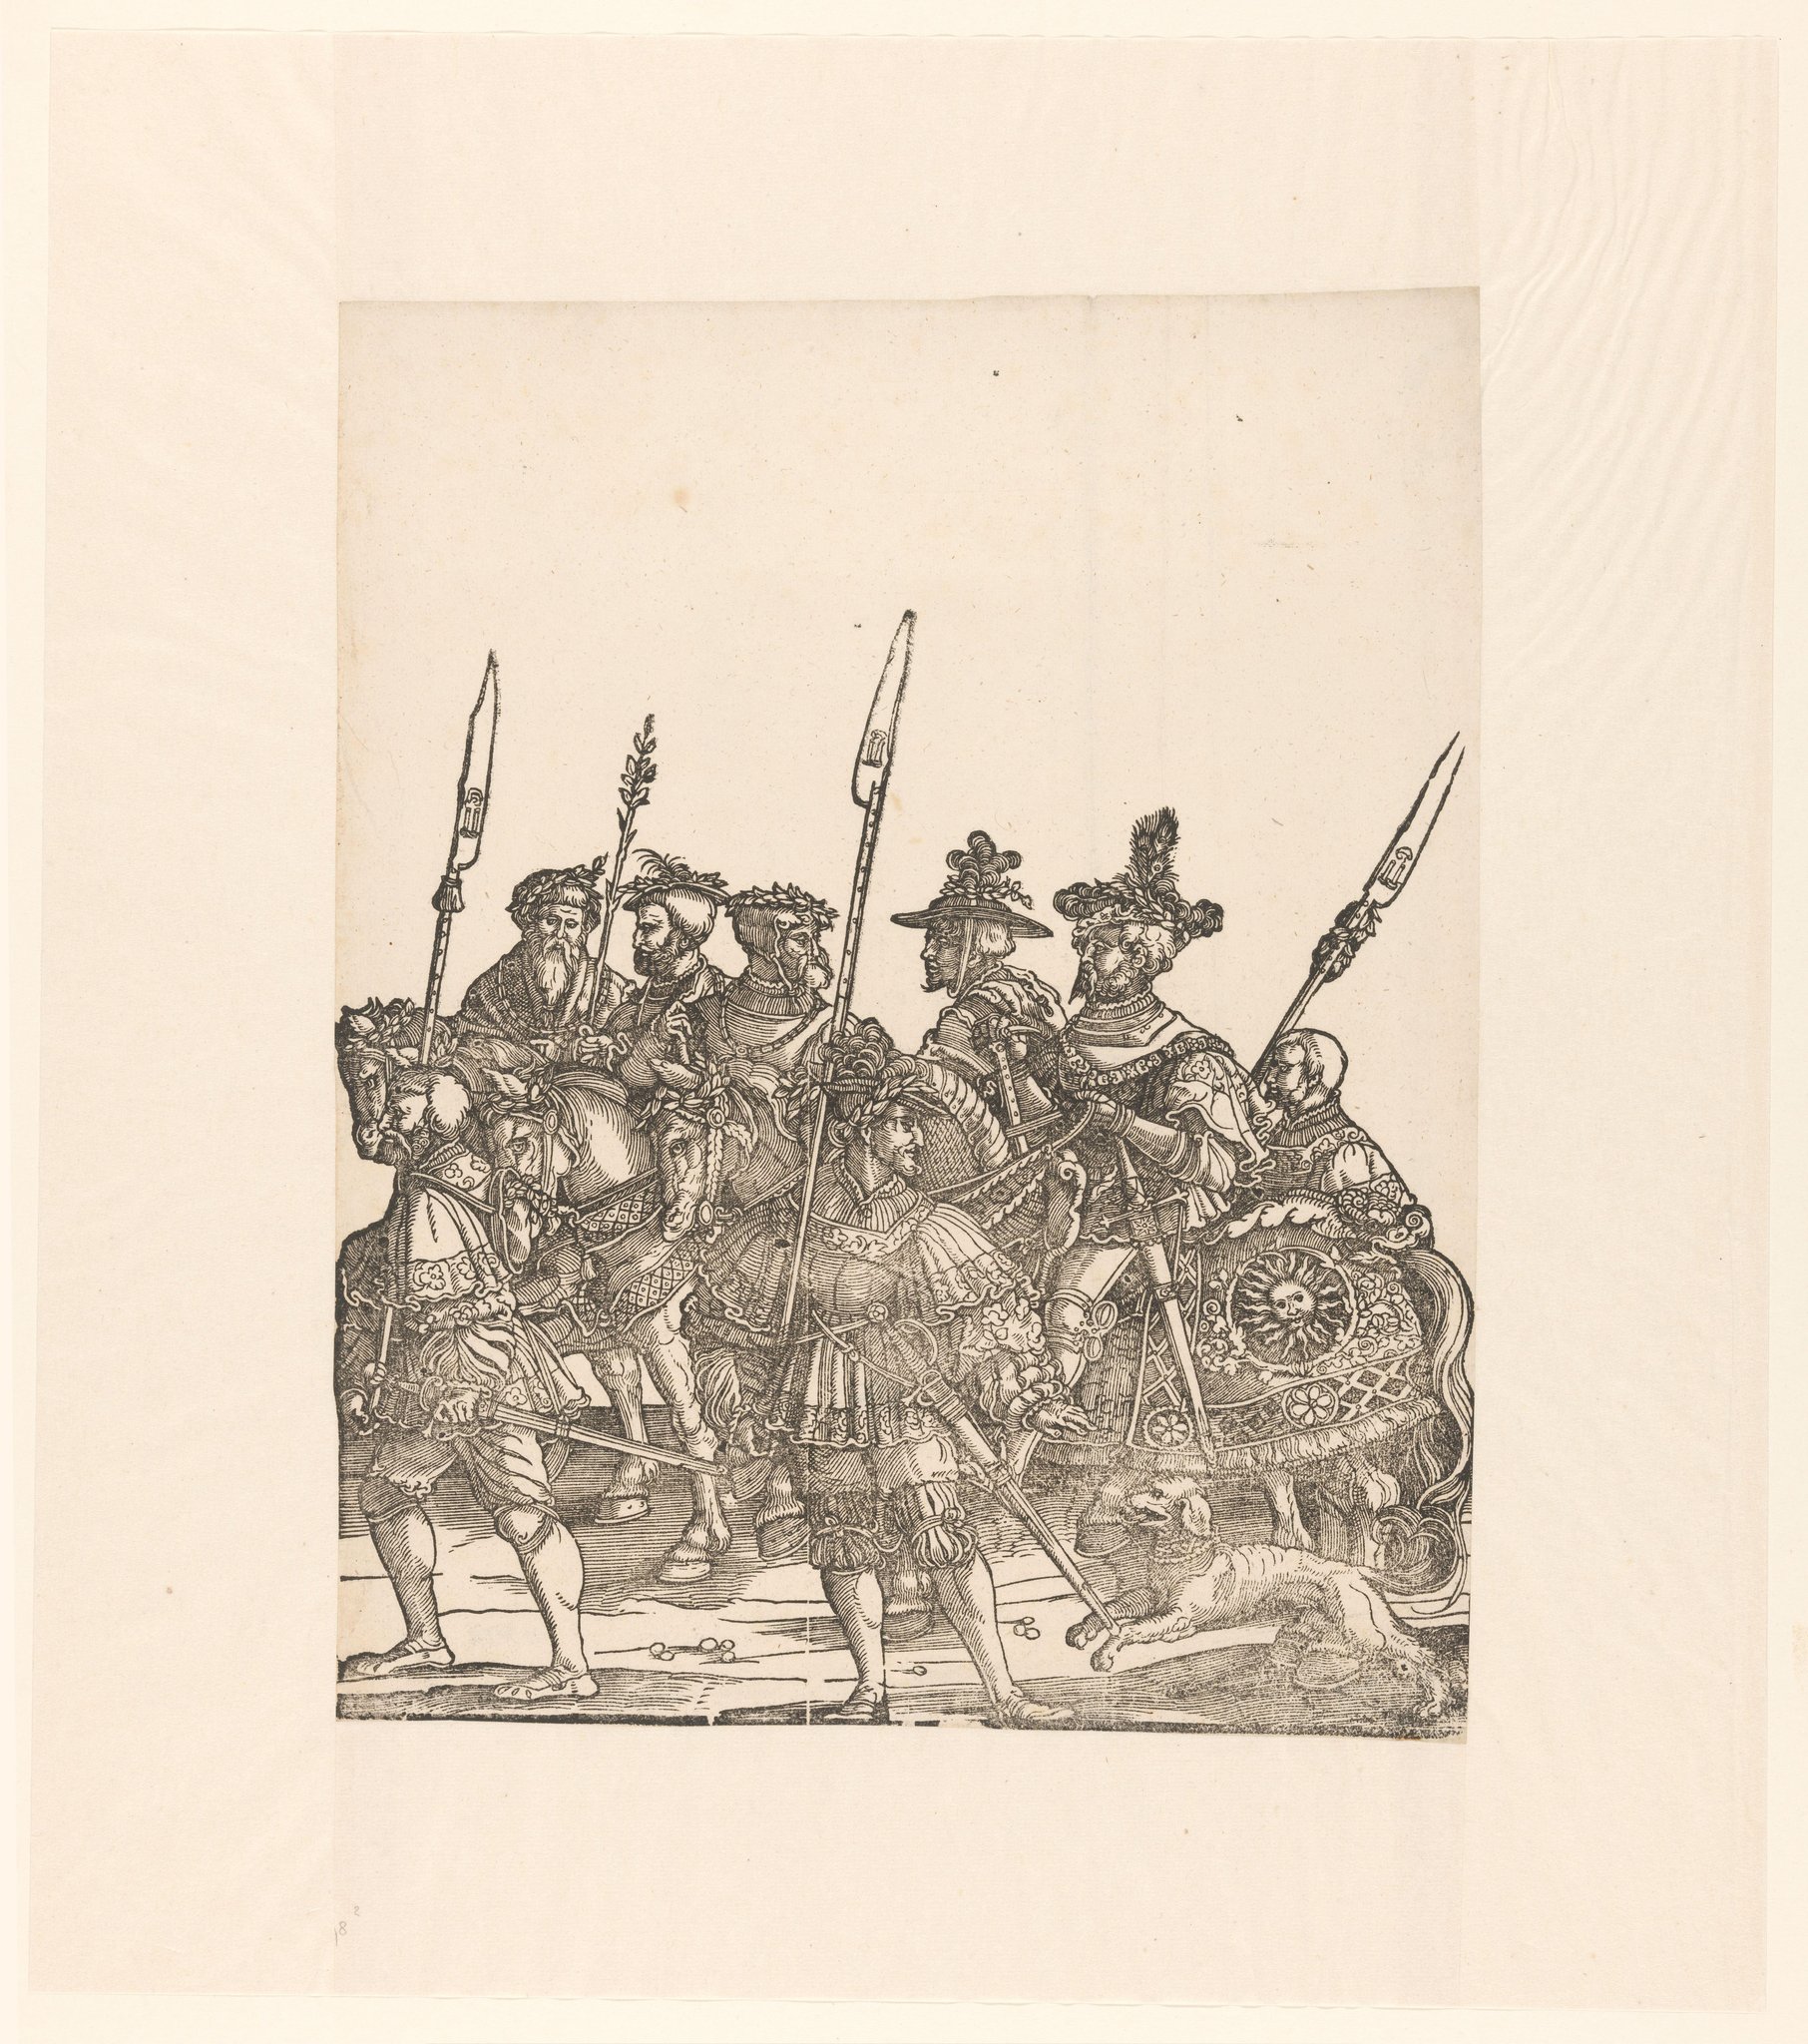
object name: print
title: Triomfwagen van Karel V, 1537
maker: hans schäufelein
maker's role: print maker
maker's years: 1480-1540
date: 1537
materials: paper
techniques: woodcut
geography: germany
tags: ghent, charles v (holy roman emperor and king of spain), chariot, triumphal car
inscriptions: collector's mark: Lugt 2166, collector's mark: Lugt 2228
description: Serie van 9 houtsneden van de triomfwagen van keizer Karel V die aan elkaar tot een doorlopend fries gemonteerd kunnen worden. De teksten boven de voorstellingen ontbreken in deze druk. Uitgave van deze tweede staat van de blokken is volgens German Hollstein (dl. XLII, p. 126) te dateren ca. 1537-1551. De watermerken van deze afdrukken wijzen op een latere datering ca. 1580-1616. De prenten worden hier beschreven naar de volgorde in Bartsch, een andere volgende dan in Hollstein en Geisberg staat, namelijk met de platen Hollstein German 51 en 52 (de plaat met het impressum) niet als de derde en vierde platen maar als achtste en negende (voorlaatste en laatste).